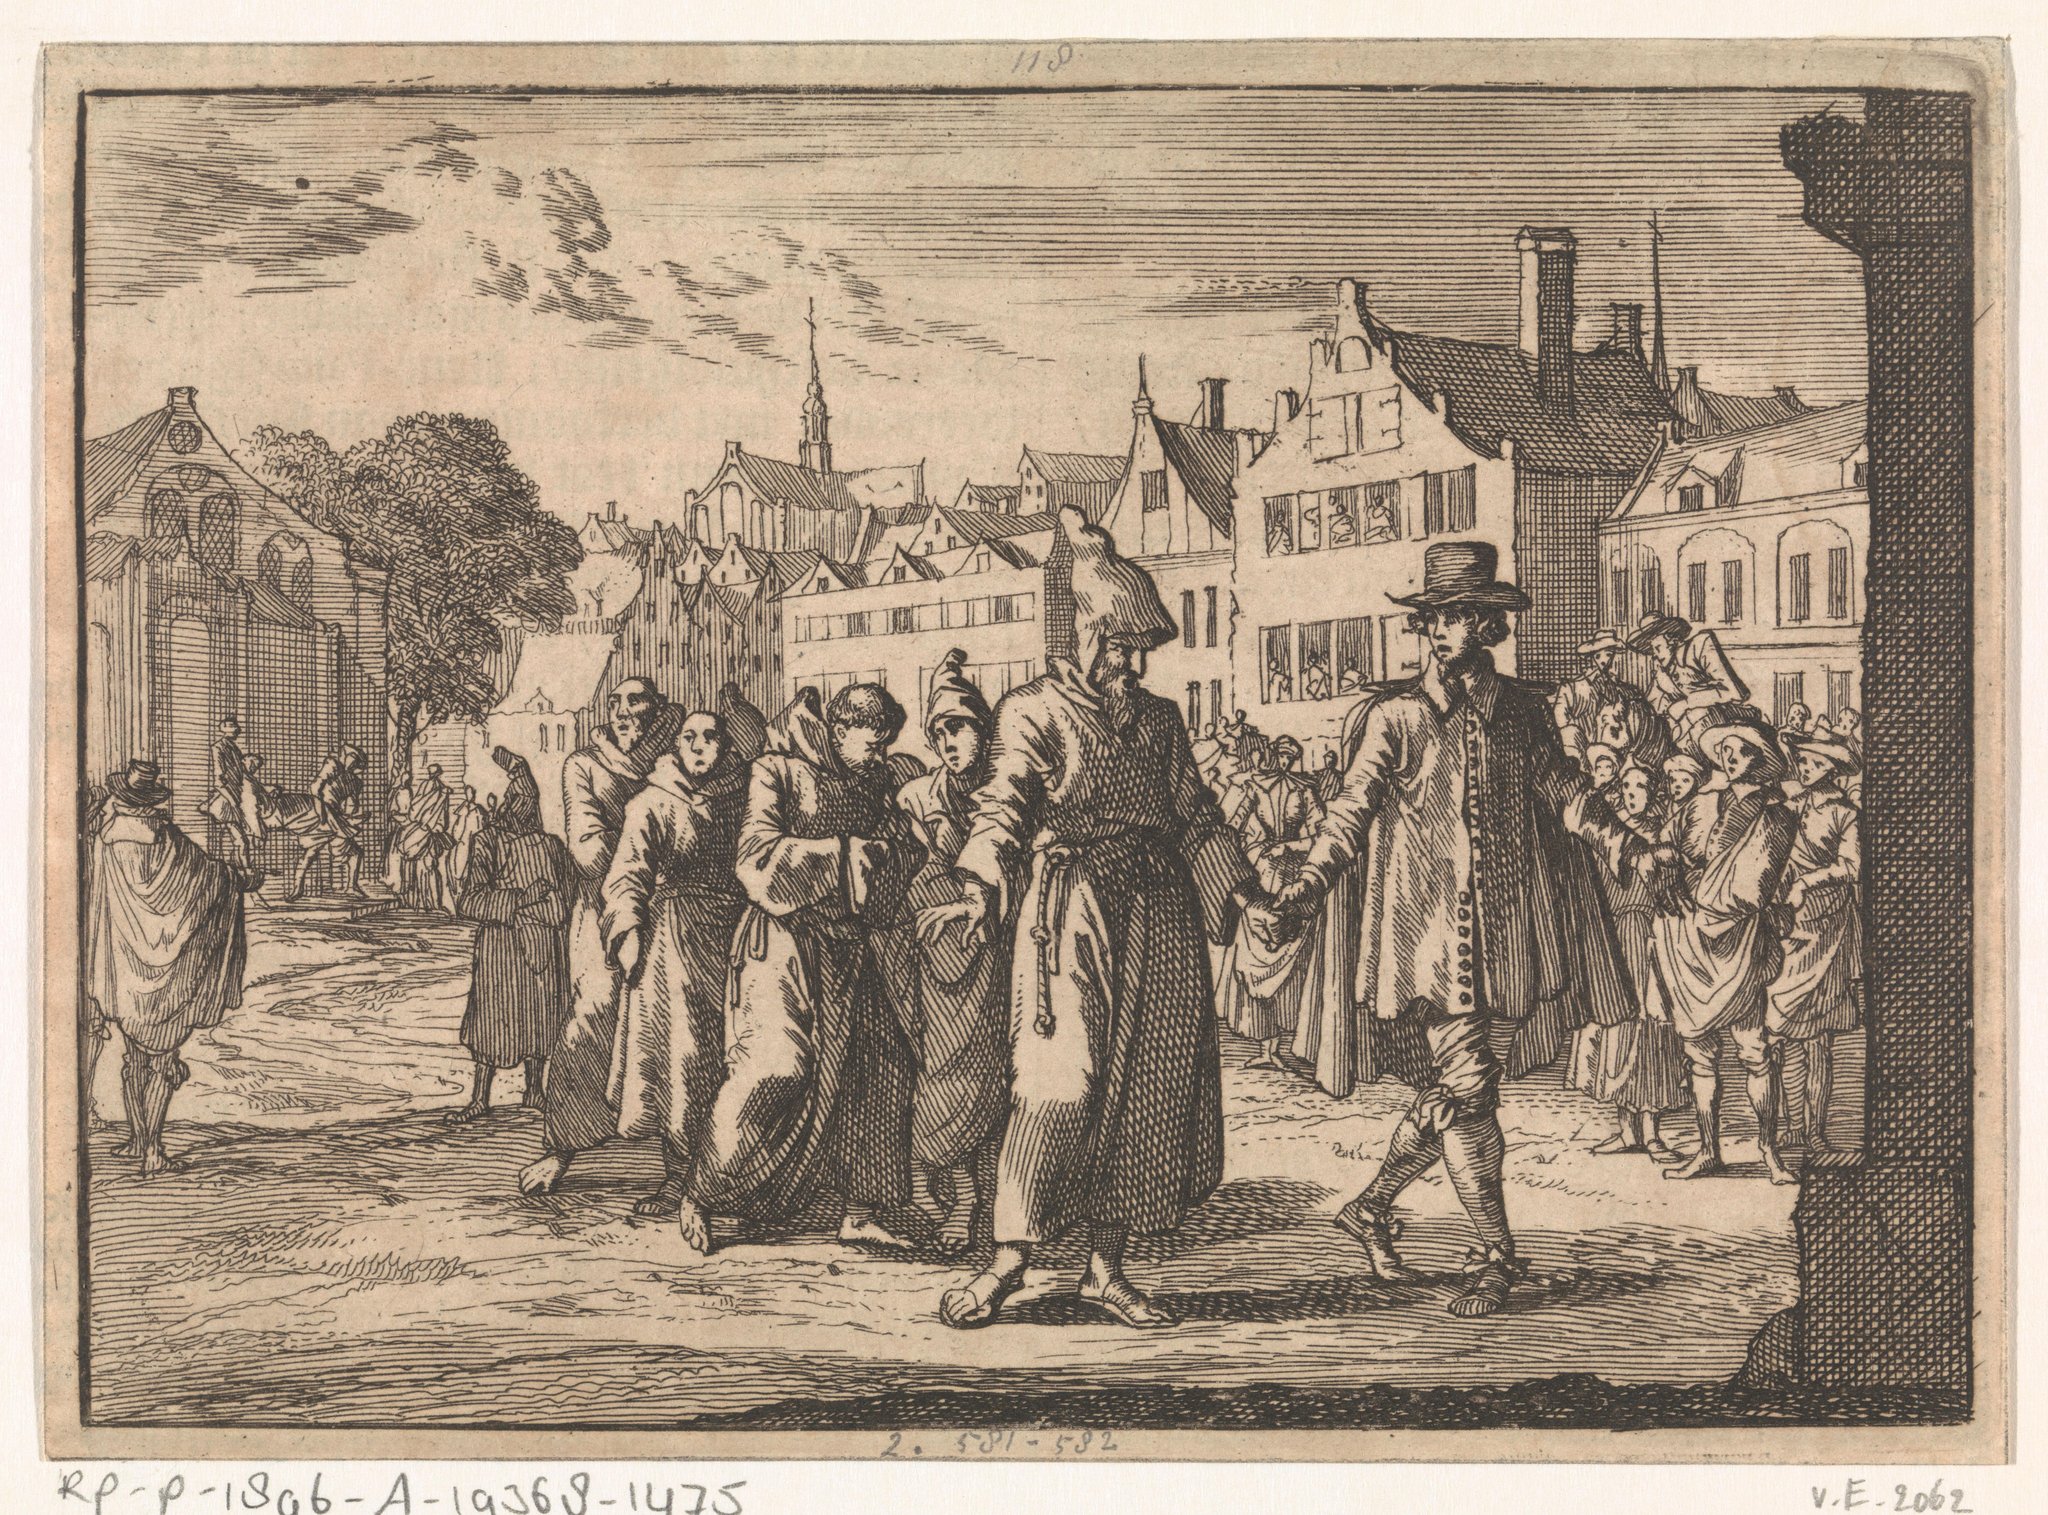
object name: book illustration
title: Te Kleef worden Capucijner monniken hun klooster uitgeleid, 1663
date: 1698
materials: paper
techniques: etching, letterpress printing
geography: amsterdam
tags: monk(s), friar(s), cloisters ~ monastery, cleves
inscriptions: collector's mark: Lugt 2228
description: Illustratie uit: Gottfried, Johann Ludwig. Historische kronyck; vervattende een (...) beschrijvingh der aldergedenckwaerdigste geschiedenissen des weerelds, van den aenvangh der scheppingh tot (...) 1576 (2 delen). Leiden: Pieter van der Aa, 1698, dl. II, p. 581.